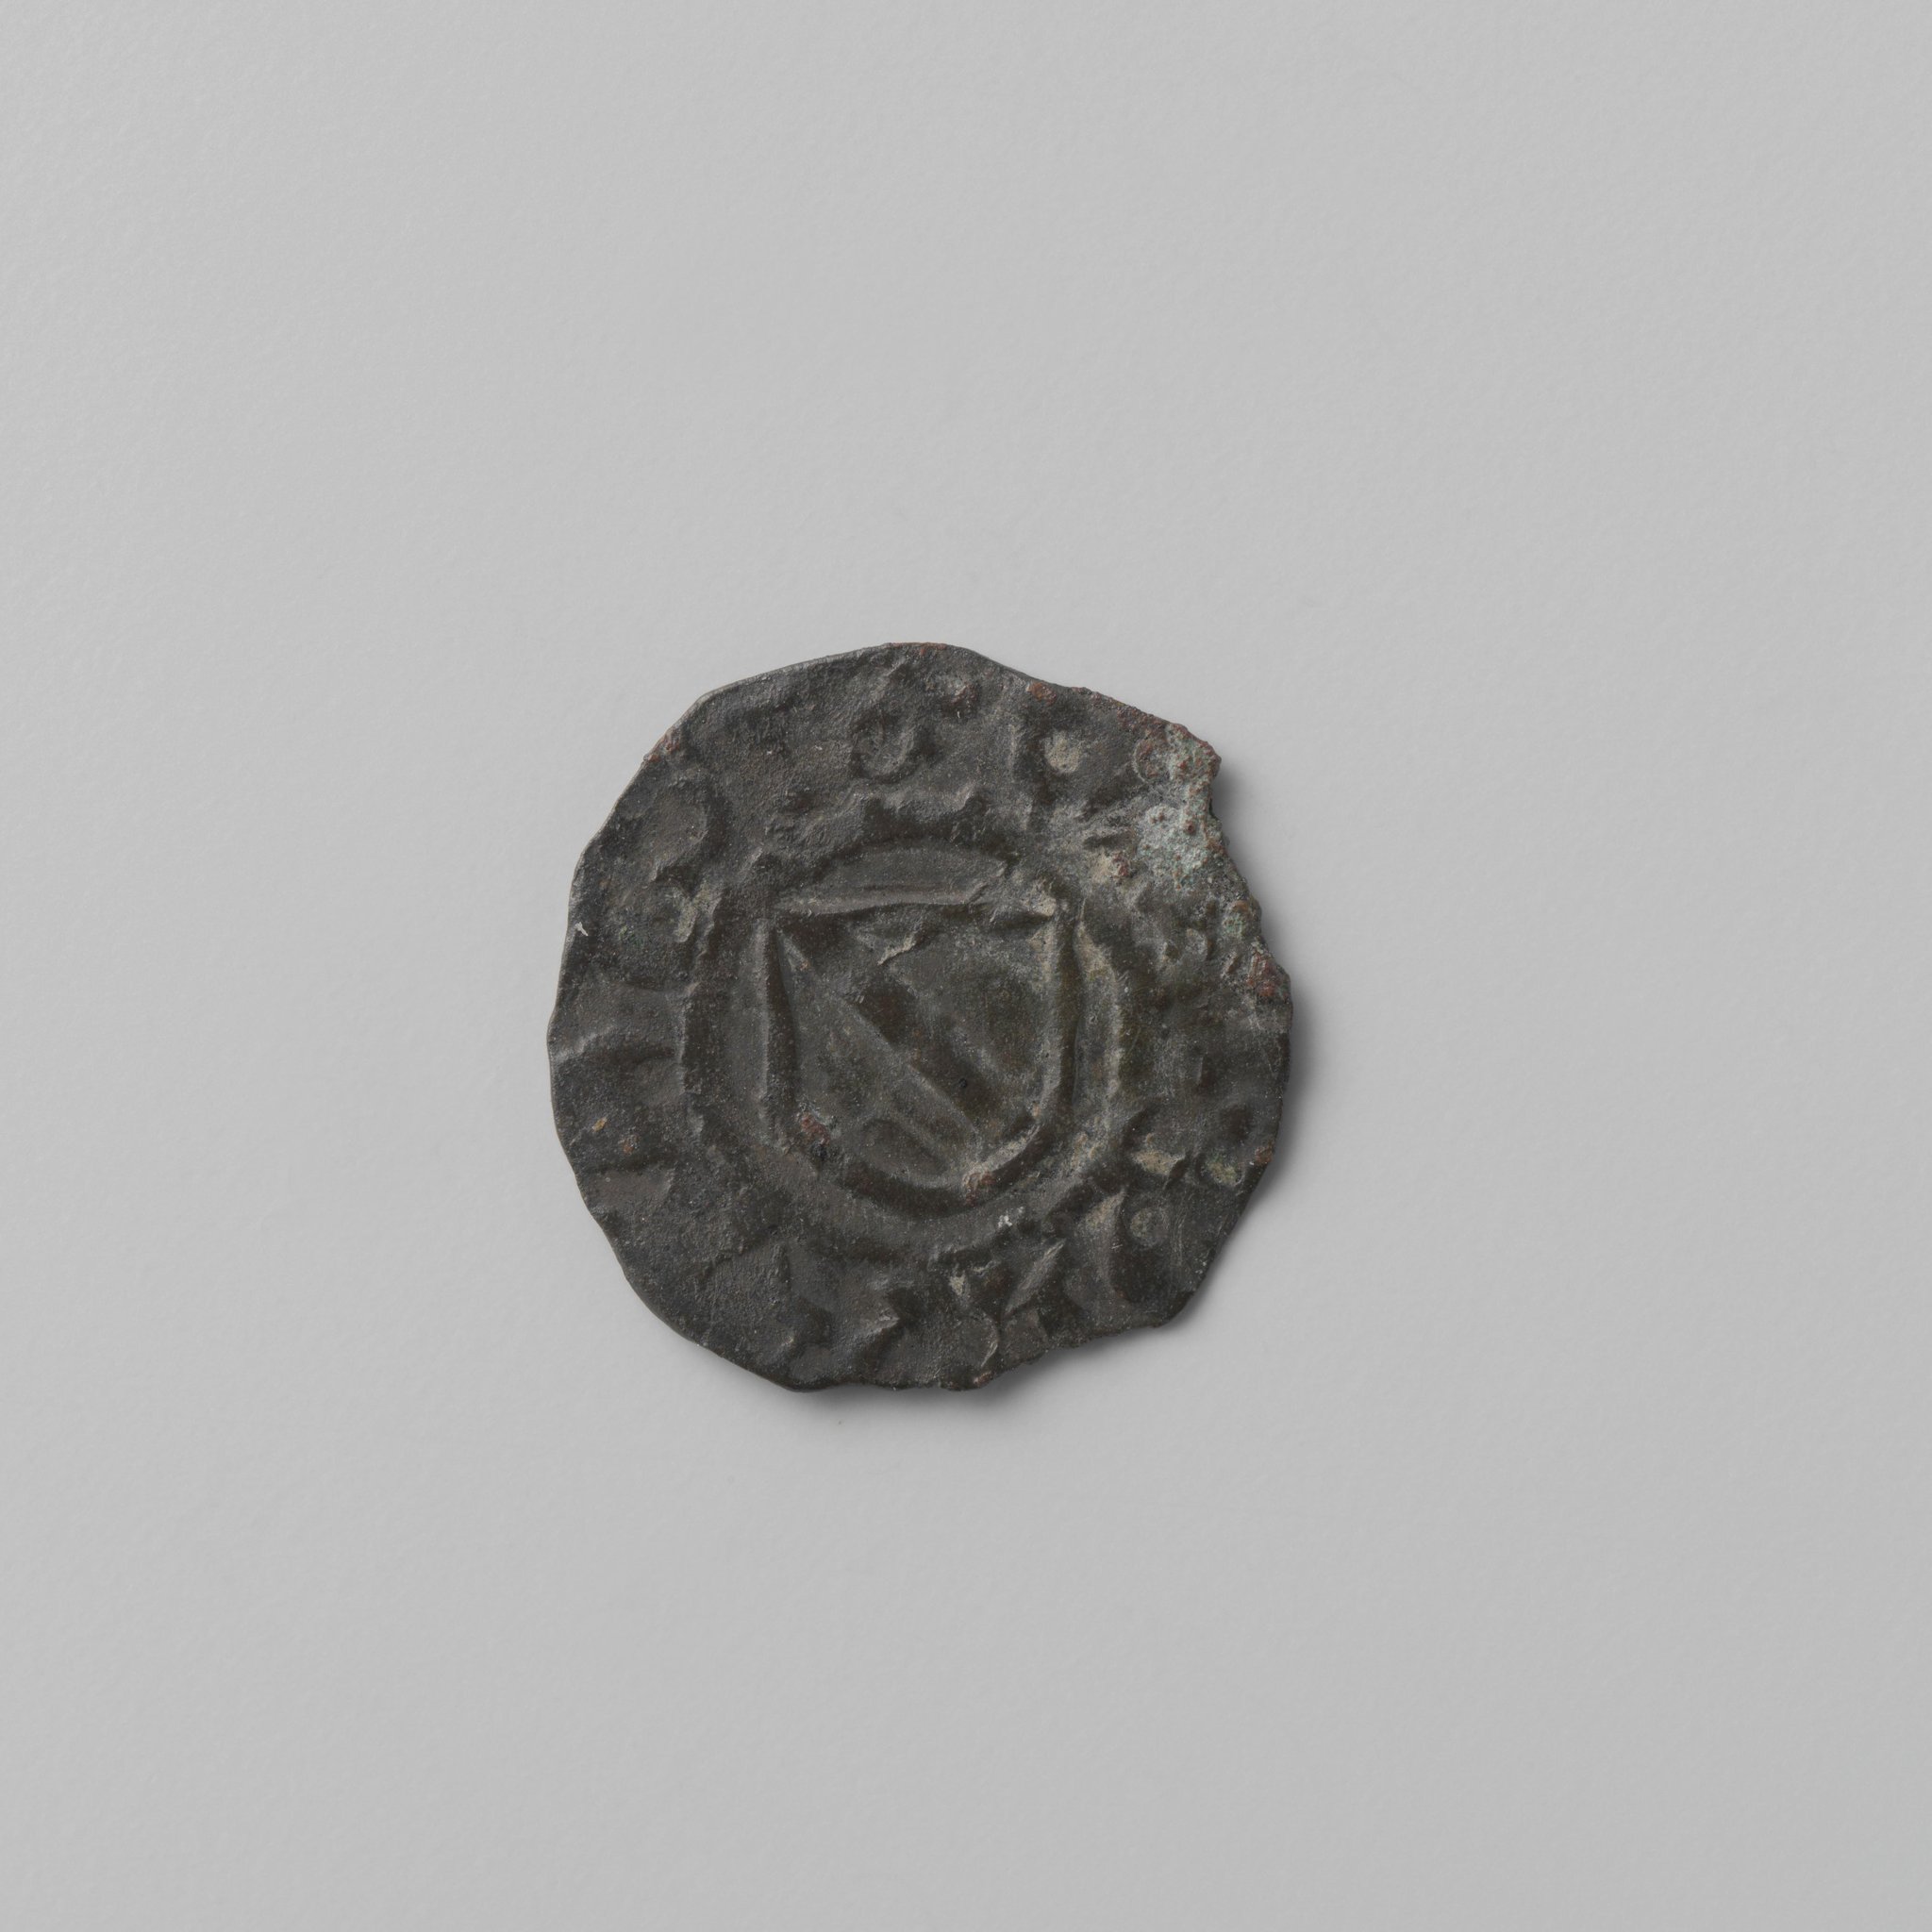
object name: coin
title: Utrechtse duit van Frederik van Baden, 1496-1516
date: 1496-1517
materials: copper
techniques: striking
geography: wijk bij duurstede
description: Koper-zilveren munt. Voorzijde: wapenschild. Keerzijde: lang gevoet kruis met in het hart wapenschildje.